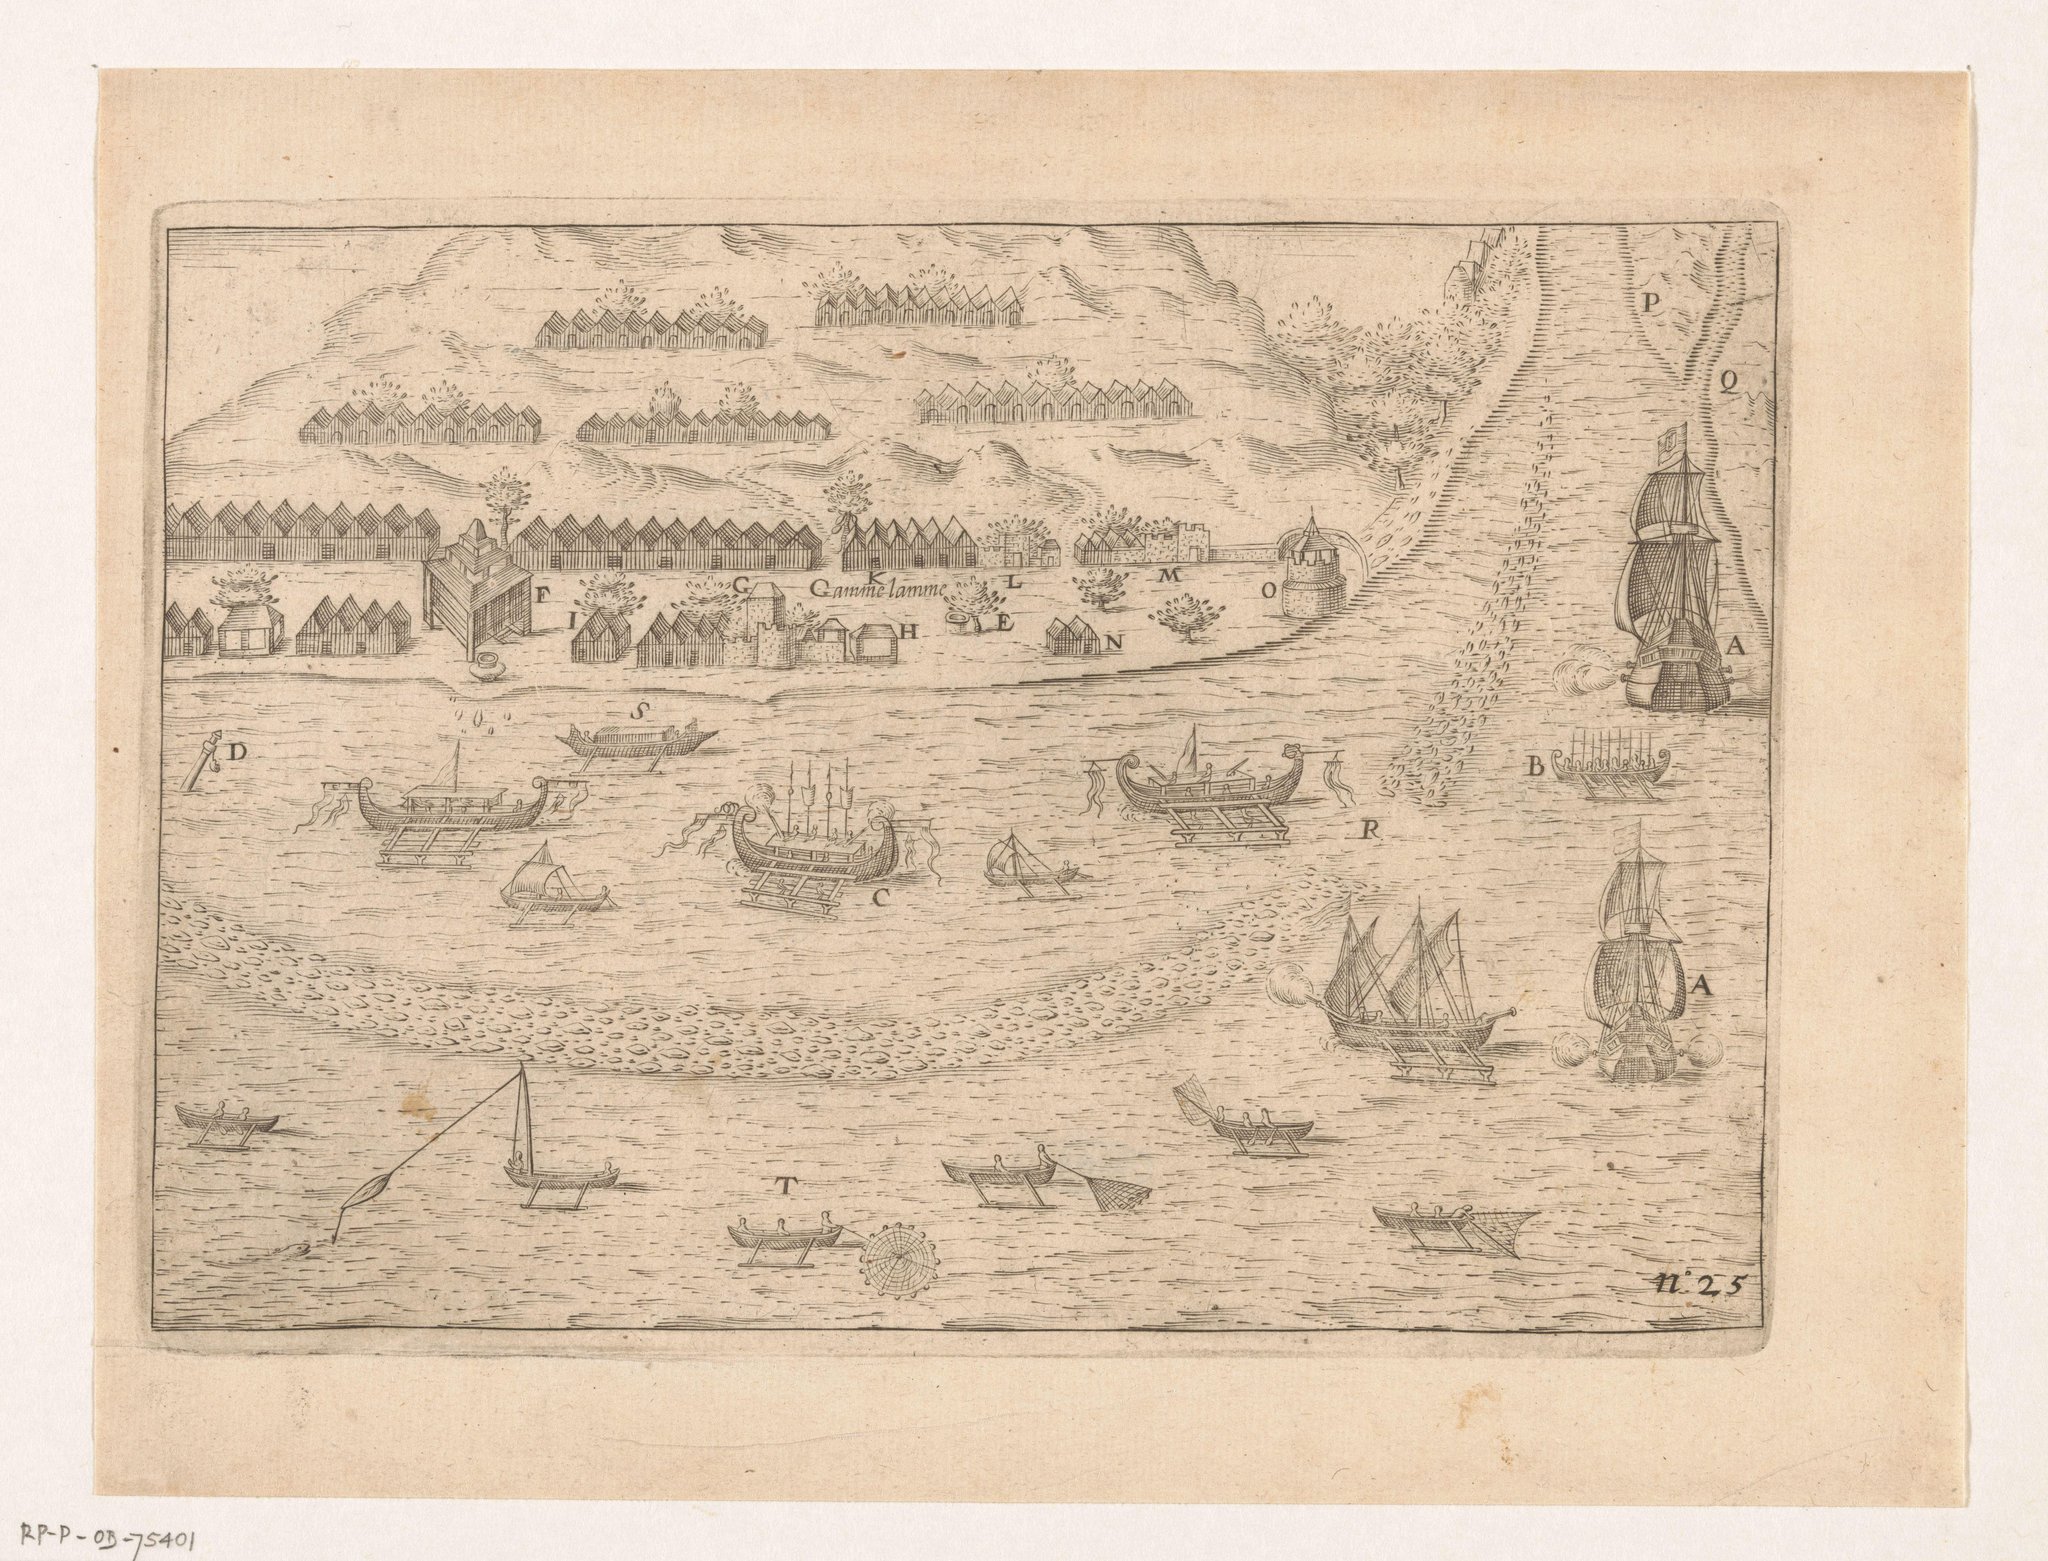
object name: print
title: Gammelamme op het eiland Ternate, 1599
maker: Anonymous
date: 1600-1601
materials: paper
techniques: engraving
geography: northern netherlands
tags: mayor, landscapes in tropical and sub-tropical regions, exploration, expedition, voyage of discovery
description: Gebruikt als illustratie eerst in: Journael ofte Dagh-register, inhoudende een waerachtigh verhael ... vande reyse, ghedaen door de acht schepen van Amsterdamme, onde 'tbeleydt van Iacob Cornelisz. Neck. als Admirael, ende VVybrandt van VVarvvijck, als Vice-admirael, van Amsterdam gheseylt inden jare 1598, Cornelis Claes, Amsterdam [1600], plaat No. 15. In deze staat gebruikt in: Oost-Indische ende West-Indische voyagien, Michiel Colijn, Amsterdam 1619 en later in: Waerachtigh verhael van de Schipvaerd op Oost-Indien ghedaen by de acht Schepen in den jare 1598 van Amsterdam uyt-ghezeylt, onder 't beleyd van den Admirael Jacob Cornelissoon van Neck, ende Vice-Admirael Wybrand van Warwijck. Opgenomen in: I. Commelin, Begin ende voortgangh, van de Vereenighde Nederlantsche Geoctroyeerde Oost-Indische Compagnie, J. Janssonius, Amsterdam 1646. Genummerd: 25.